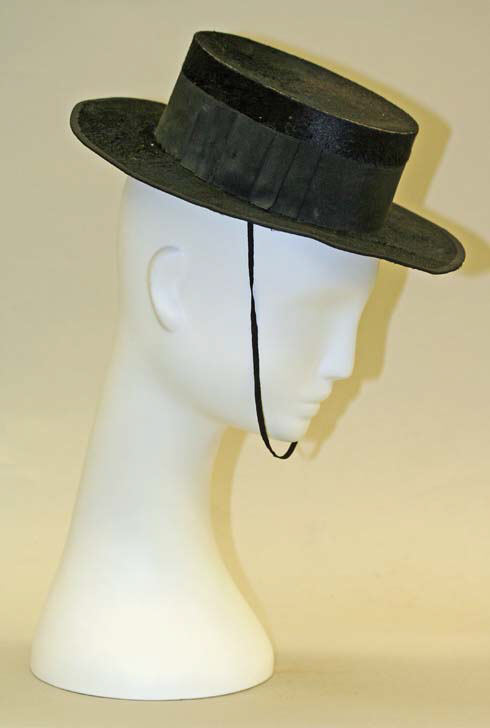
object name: hat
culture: american or european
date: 1865